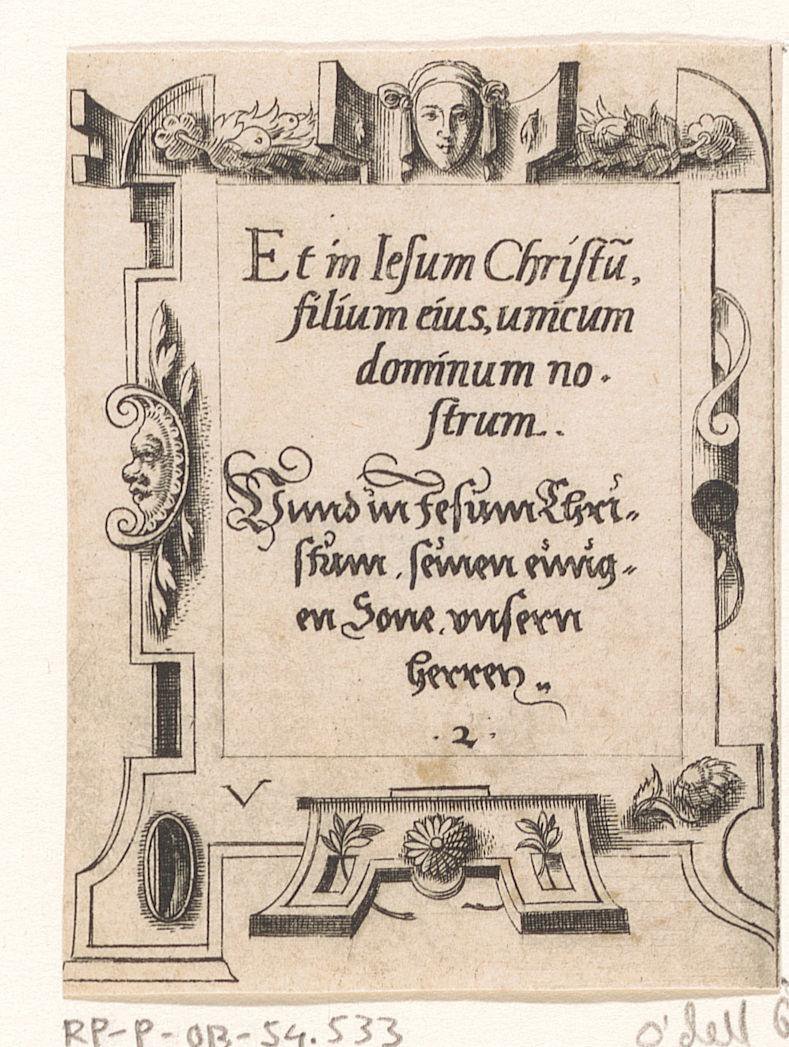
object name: print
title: Gebed in Latijn en Duits in een rolwerk omlijsting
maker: virgilius solis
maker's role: draughtsman, print maker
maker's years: 1514-1562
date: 1568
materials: paper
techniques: engraving, etching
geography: nuremberg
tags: scrollwork, strapwork ~ ornament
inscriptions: collector's mark: Lugt 240, number: ‘87’, collector's mark: Lugt 2228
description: Prent gebruikt voor het gebedenboek: Solis, Virgil. Ein New Künstlich Betbüchlein. Neurenberg: Hieronymus Petri, 1568. Bij elke prent met afbeelding van een apostel behoort een prent met een gebed in het Latijn en in het Duits. Bij elkaar horende prenten hebben dezelfde nummering en het monogram VS is steeds verspreid over twee bladen met dezelfde nummering.